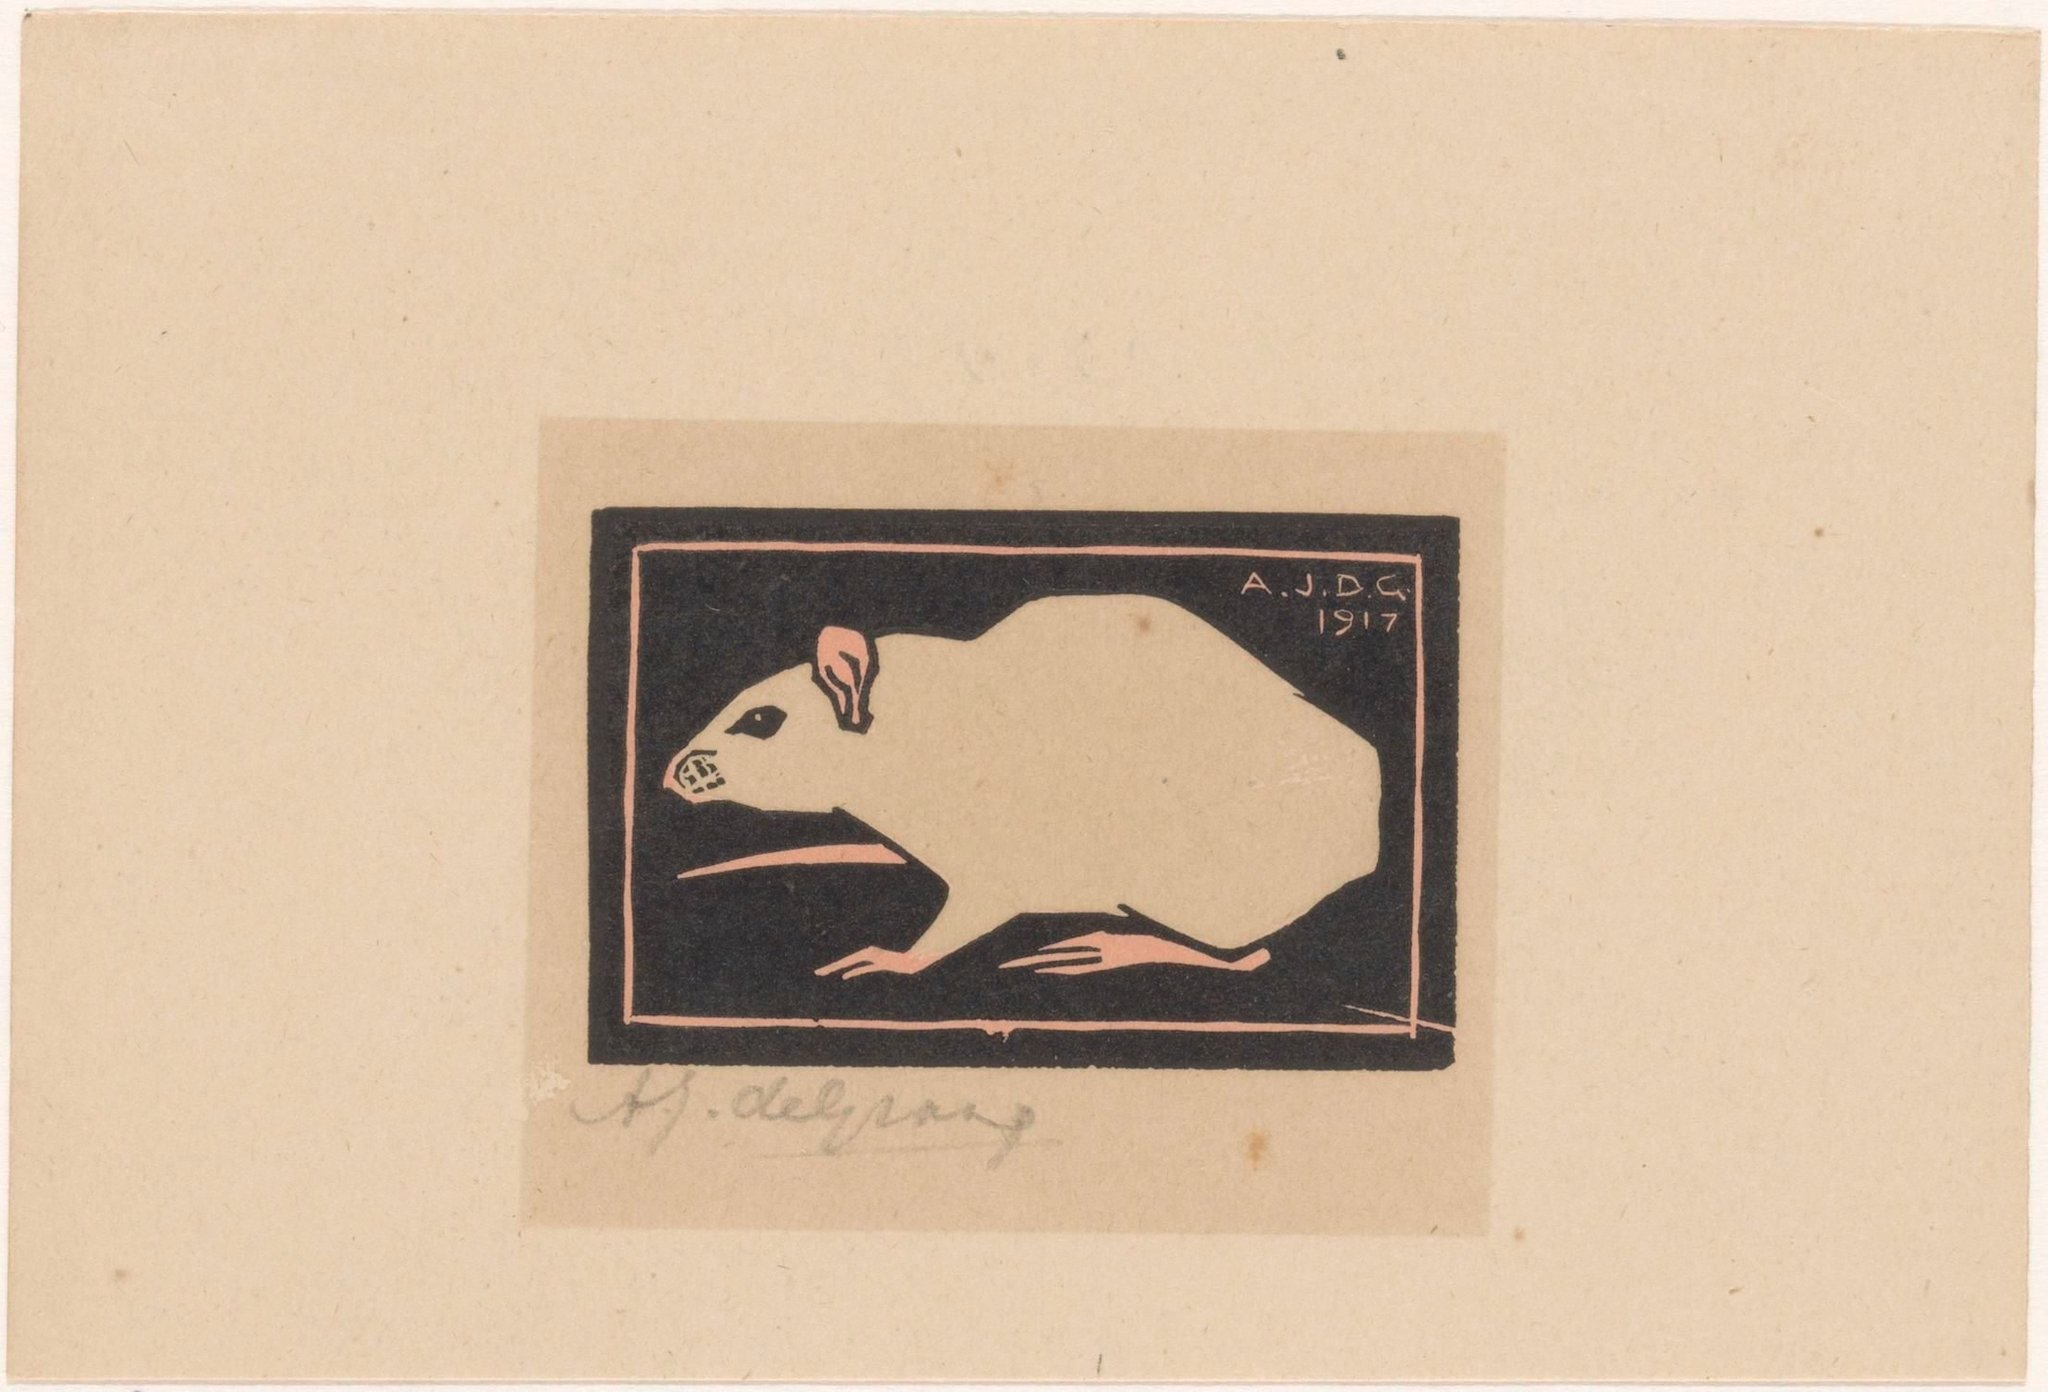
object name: print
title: Muis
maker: julie de graag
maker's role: draughtsman, print maker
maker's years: 1877-1924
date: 1917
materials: paper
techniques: woodcut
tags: rodents: mouse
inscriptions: collector's mark: Lugt 2228